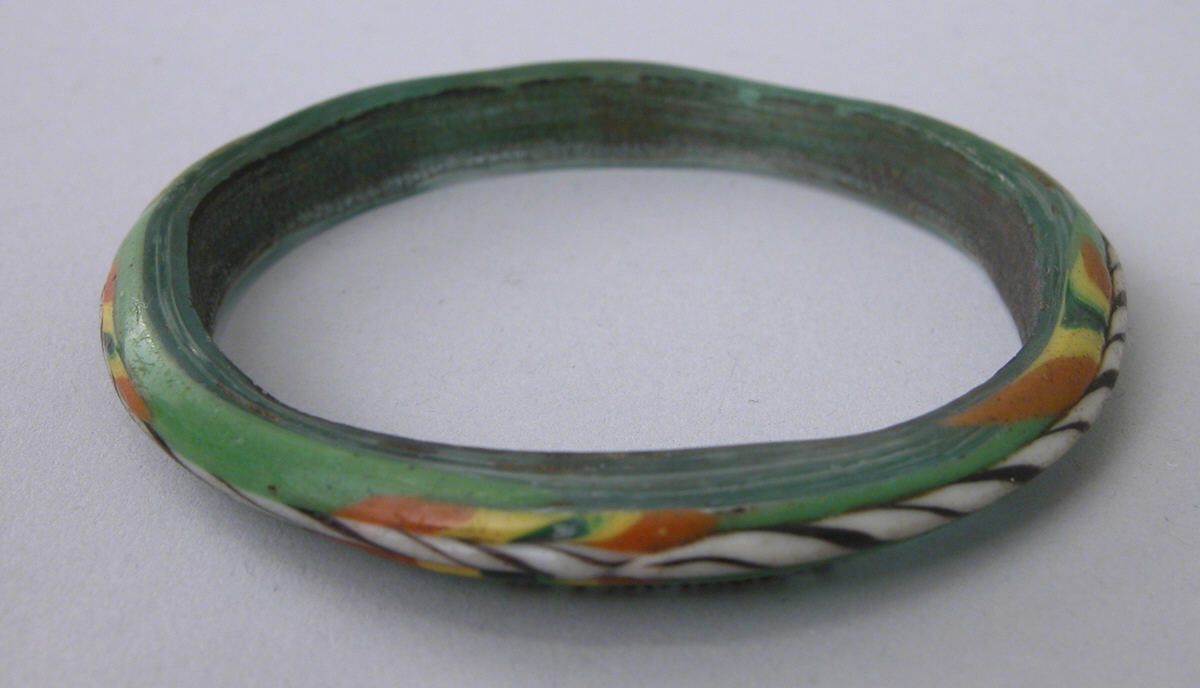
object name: bracelet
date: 1301-1500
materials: glass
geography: egypt or syria